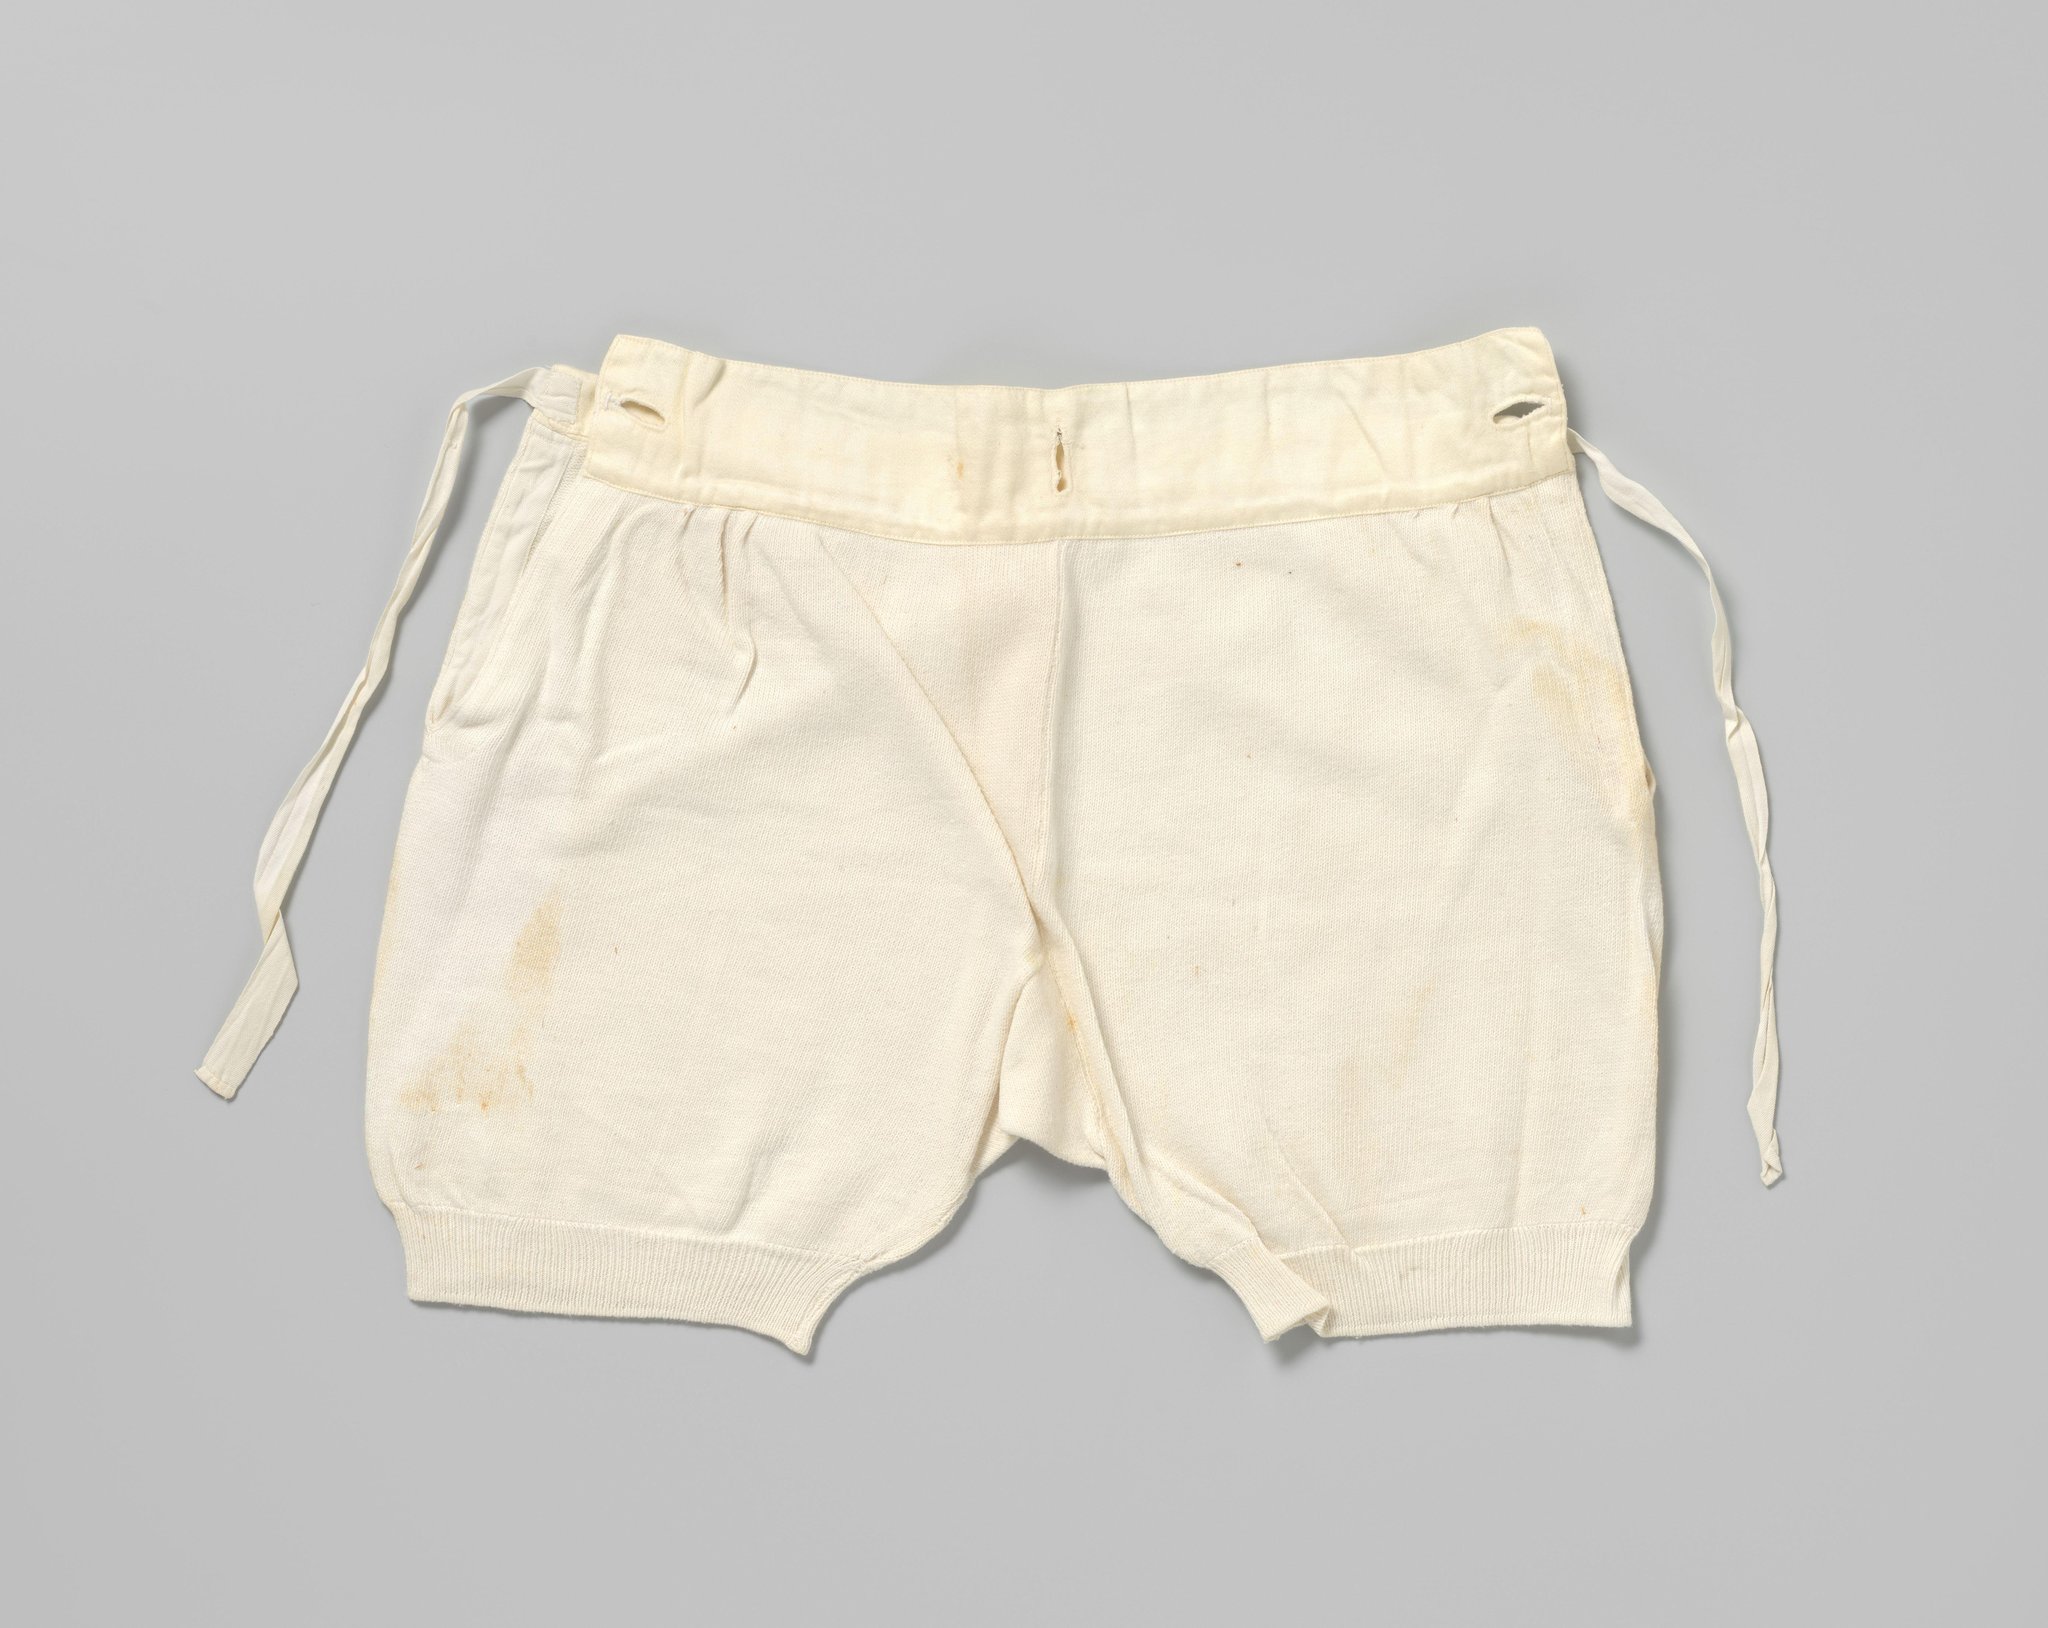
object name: childrenswear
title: Witte katoenen onderbroek met korte pijpen voor kind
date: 1900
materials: cotton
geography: vriezenveen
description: Onderbroek met korte pijpen voor kind, van witte katoenen tricot met tailleband van keperkatoen, gemerkt met kruissteken van rode zijde 'vR'. De tailleband is aan de voorkant breed en heeft drie gefestonneerde knoopsgaten; op de rug is hij smal en heeft aan ieder uiteinde een wit biaisband als striklint. De pijpen hebben een boord. In de linkerzijnaad gemerkt.